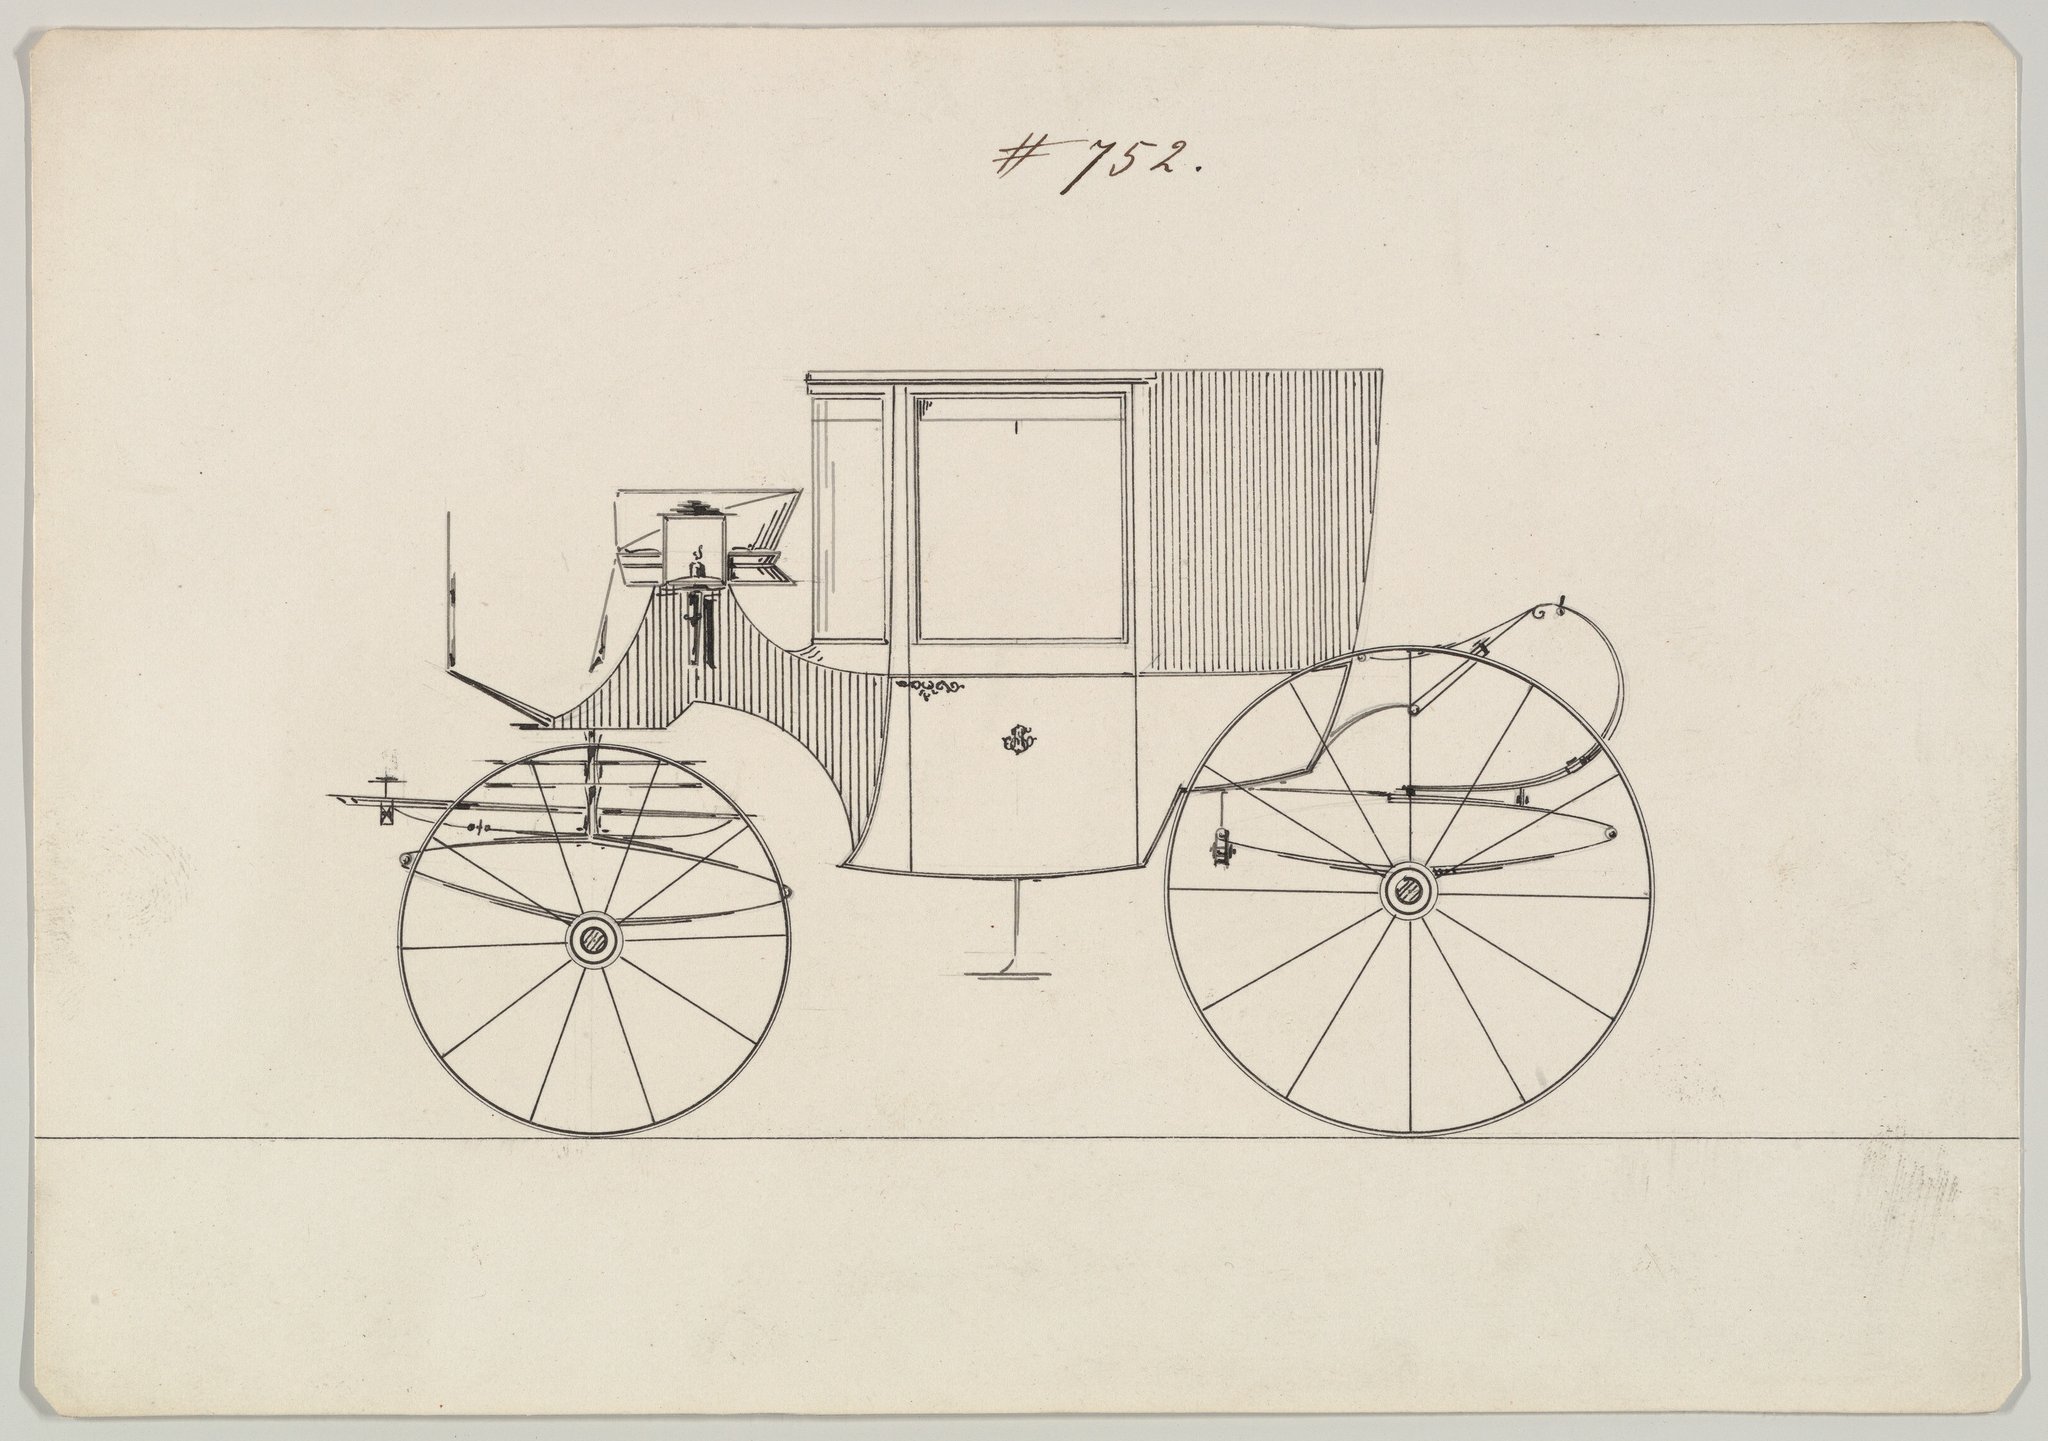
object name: drawing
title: Clarence # 752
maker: brewster & co.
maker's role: manufacturer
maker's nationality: american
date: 1850-1870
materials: ink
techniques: pen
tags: carriages